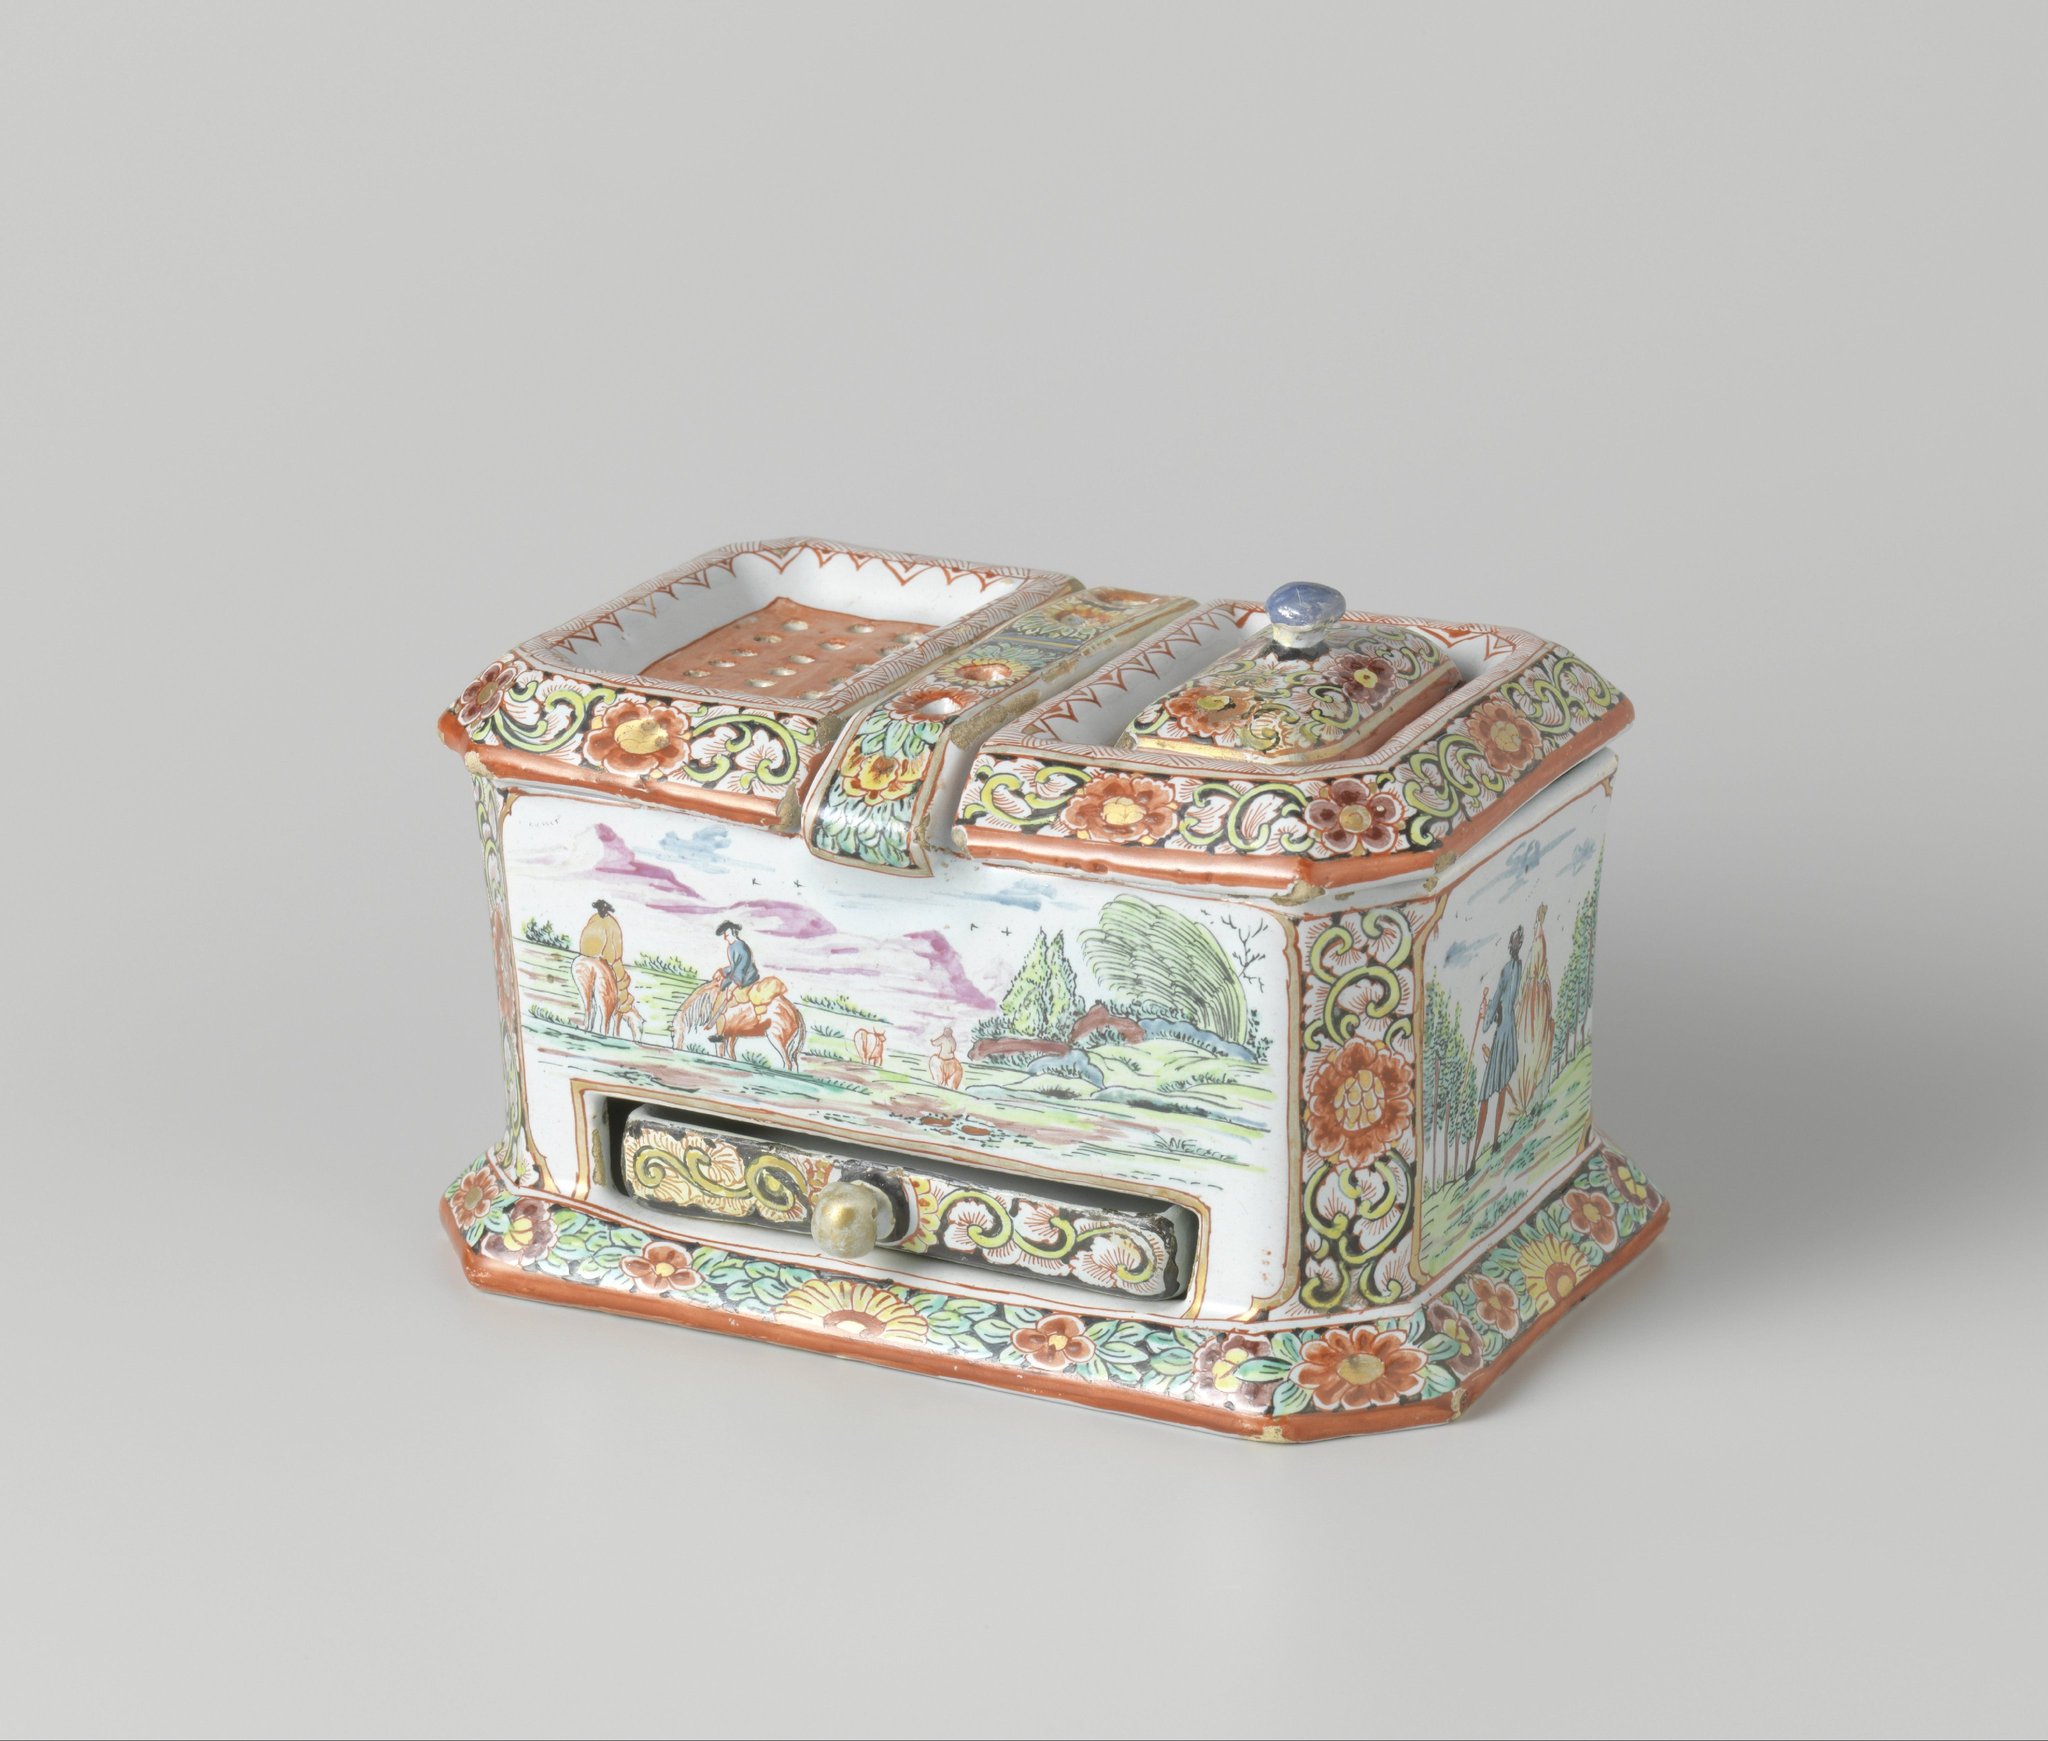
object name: inkstand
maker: Anonymous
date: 1730-1770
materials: earthenware, glaze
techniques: kiln, painted, polychromy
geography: delft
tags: ornaments ~ art, landscapes in the temperate zone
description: Inktstel, rechthoekig met afgeronde hoeken veelkleurig beschilderd met herders in een landschap.